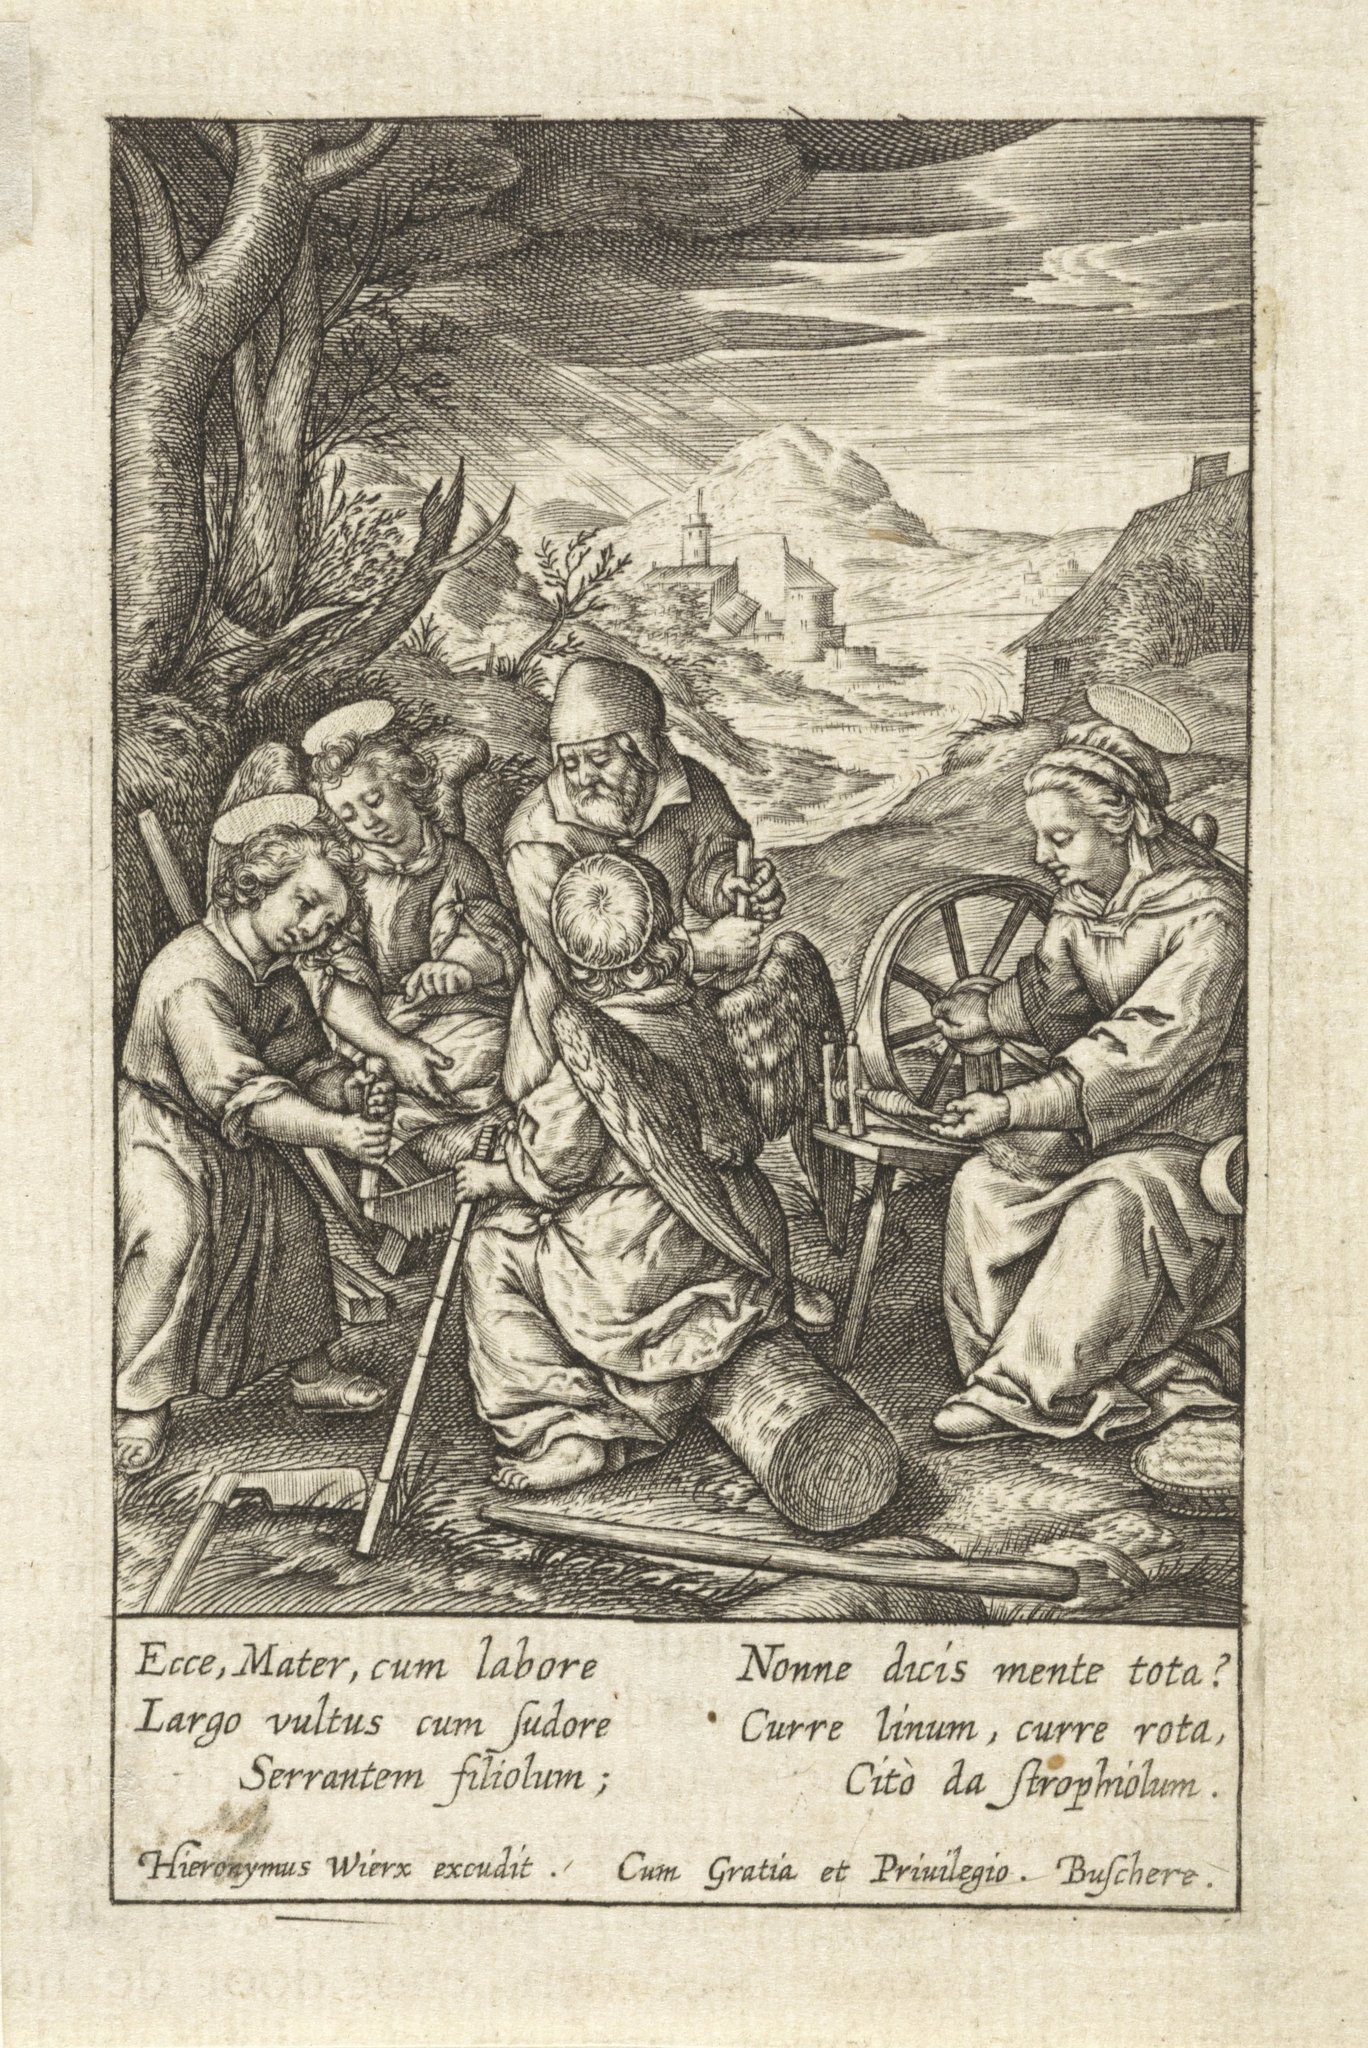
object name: print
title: Christuskind zaagt een boomstam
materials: paper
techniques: engraving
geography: antwerp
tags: joseph and the christ-child ~ daily life in nazareth, household occupations of mary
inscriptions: collector's mark: Lugt 2228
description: Het Christuskind, geholpen door twee engelen, zaagt een boomstam in stukken. Zijn vader Jozef kijkt toe. Maria is aan het spinnen. In de marge een zesregelig onderschrift, in twee kolommen, in het Latijn.